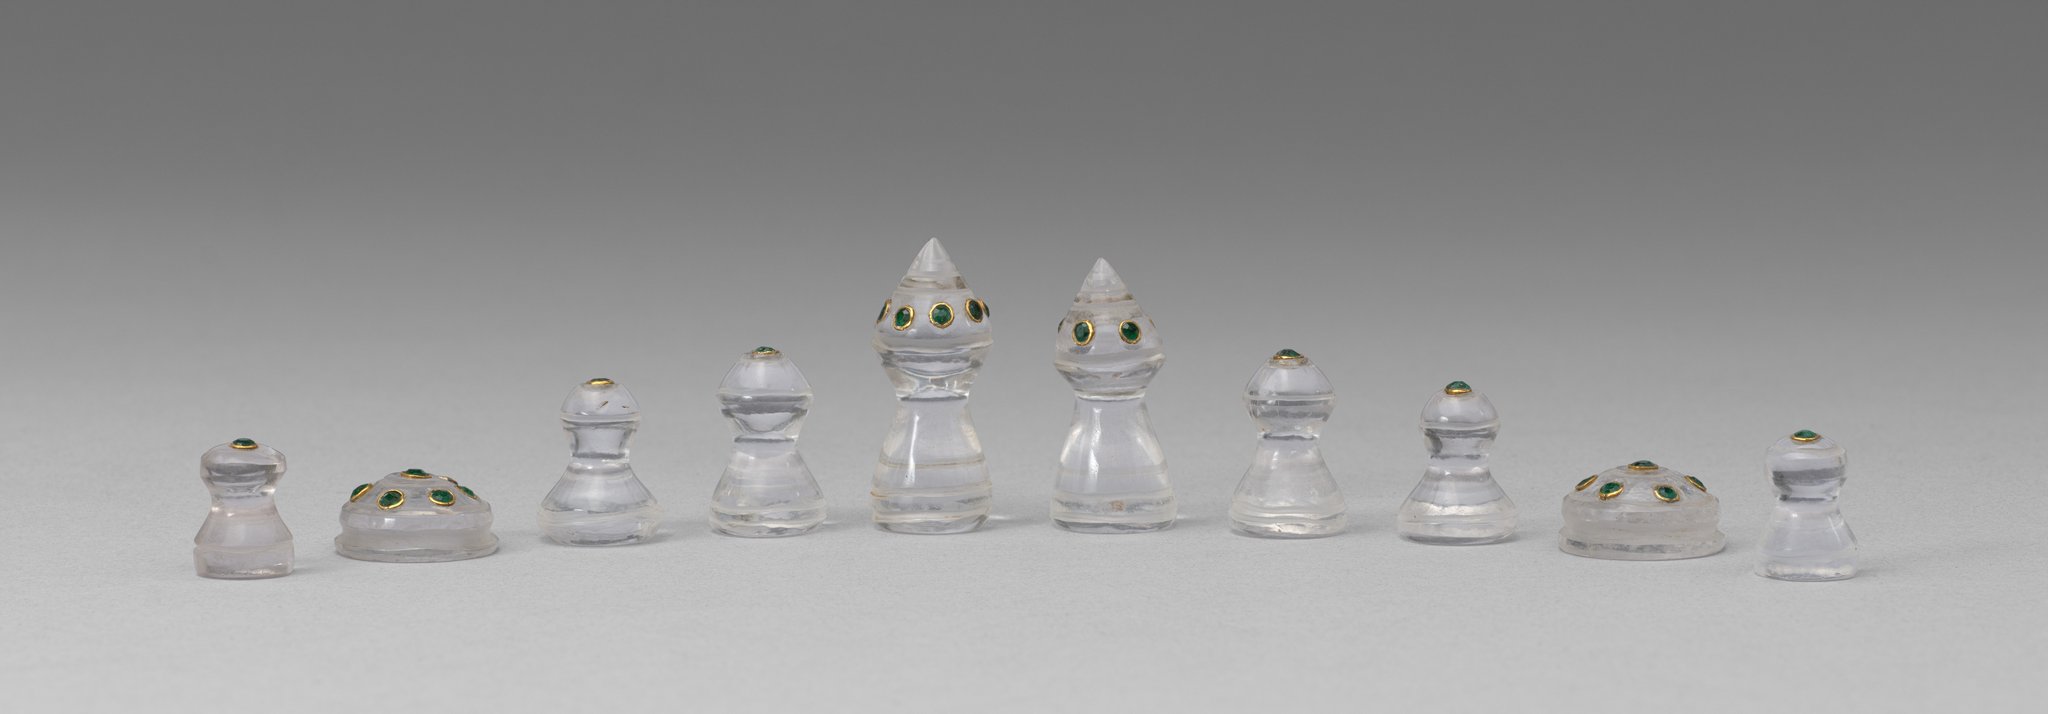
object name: chessman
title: Chessmen (32)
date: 1801-1900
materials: crystal, gemstone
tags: chess,games